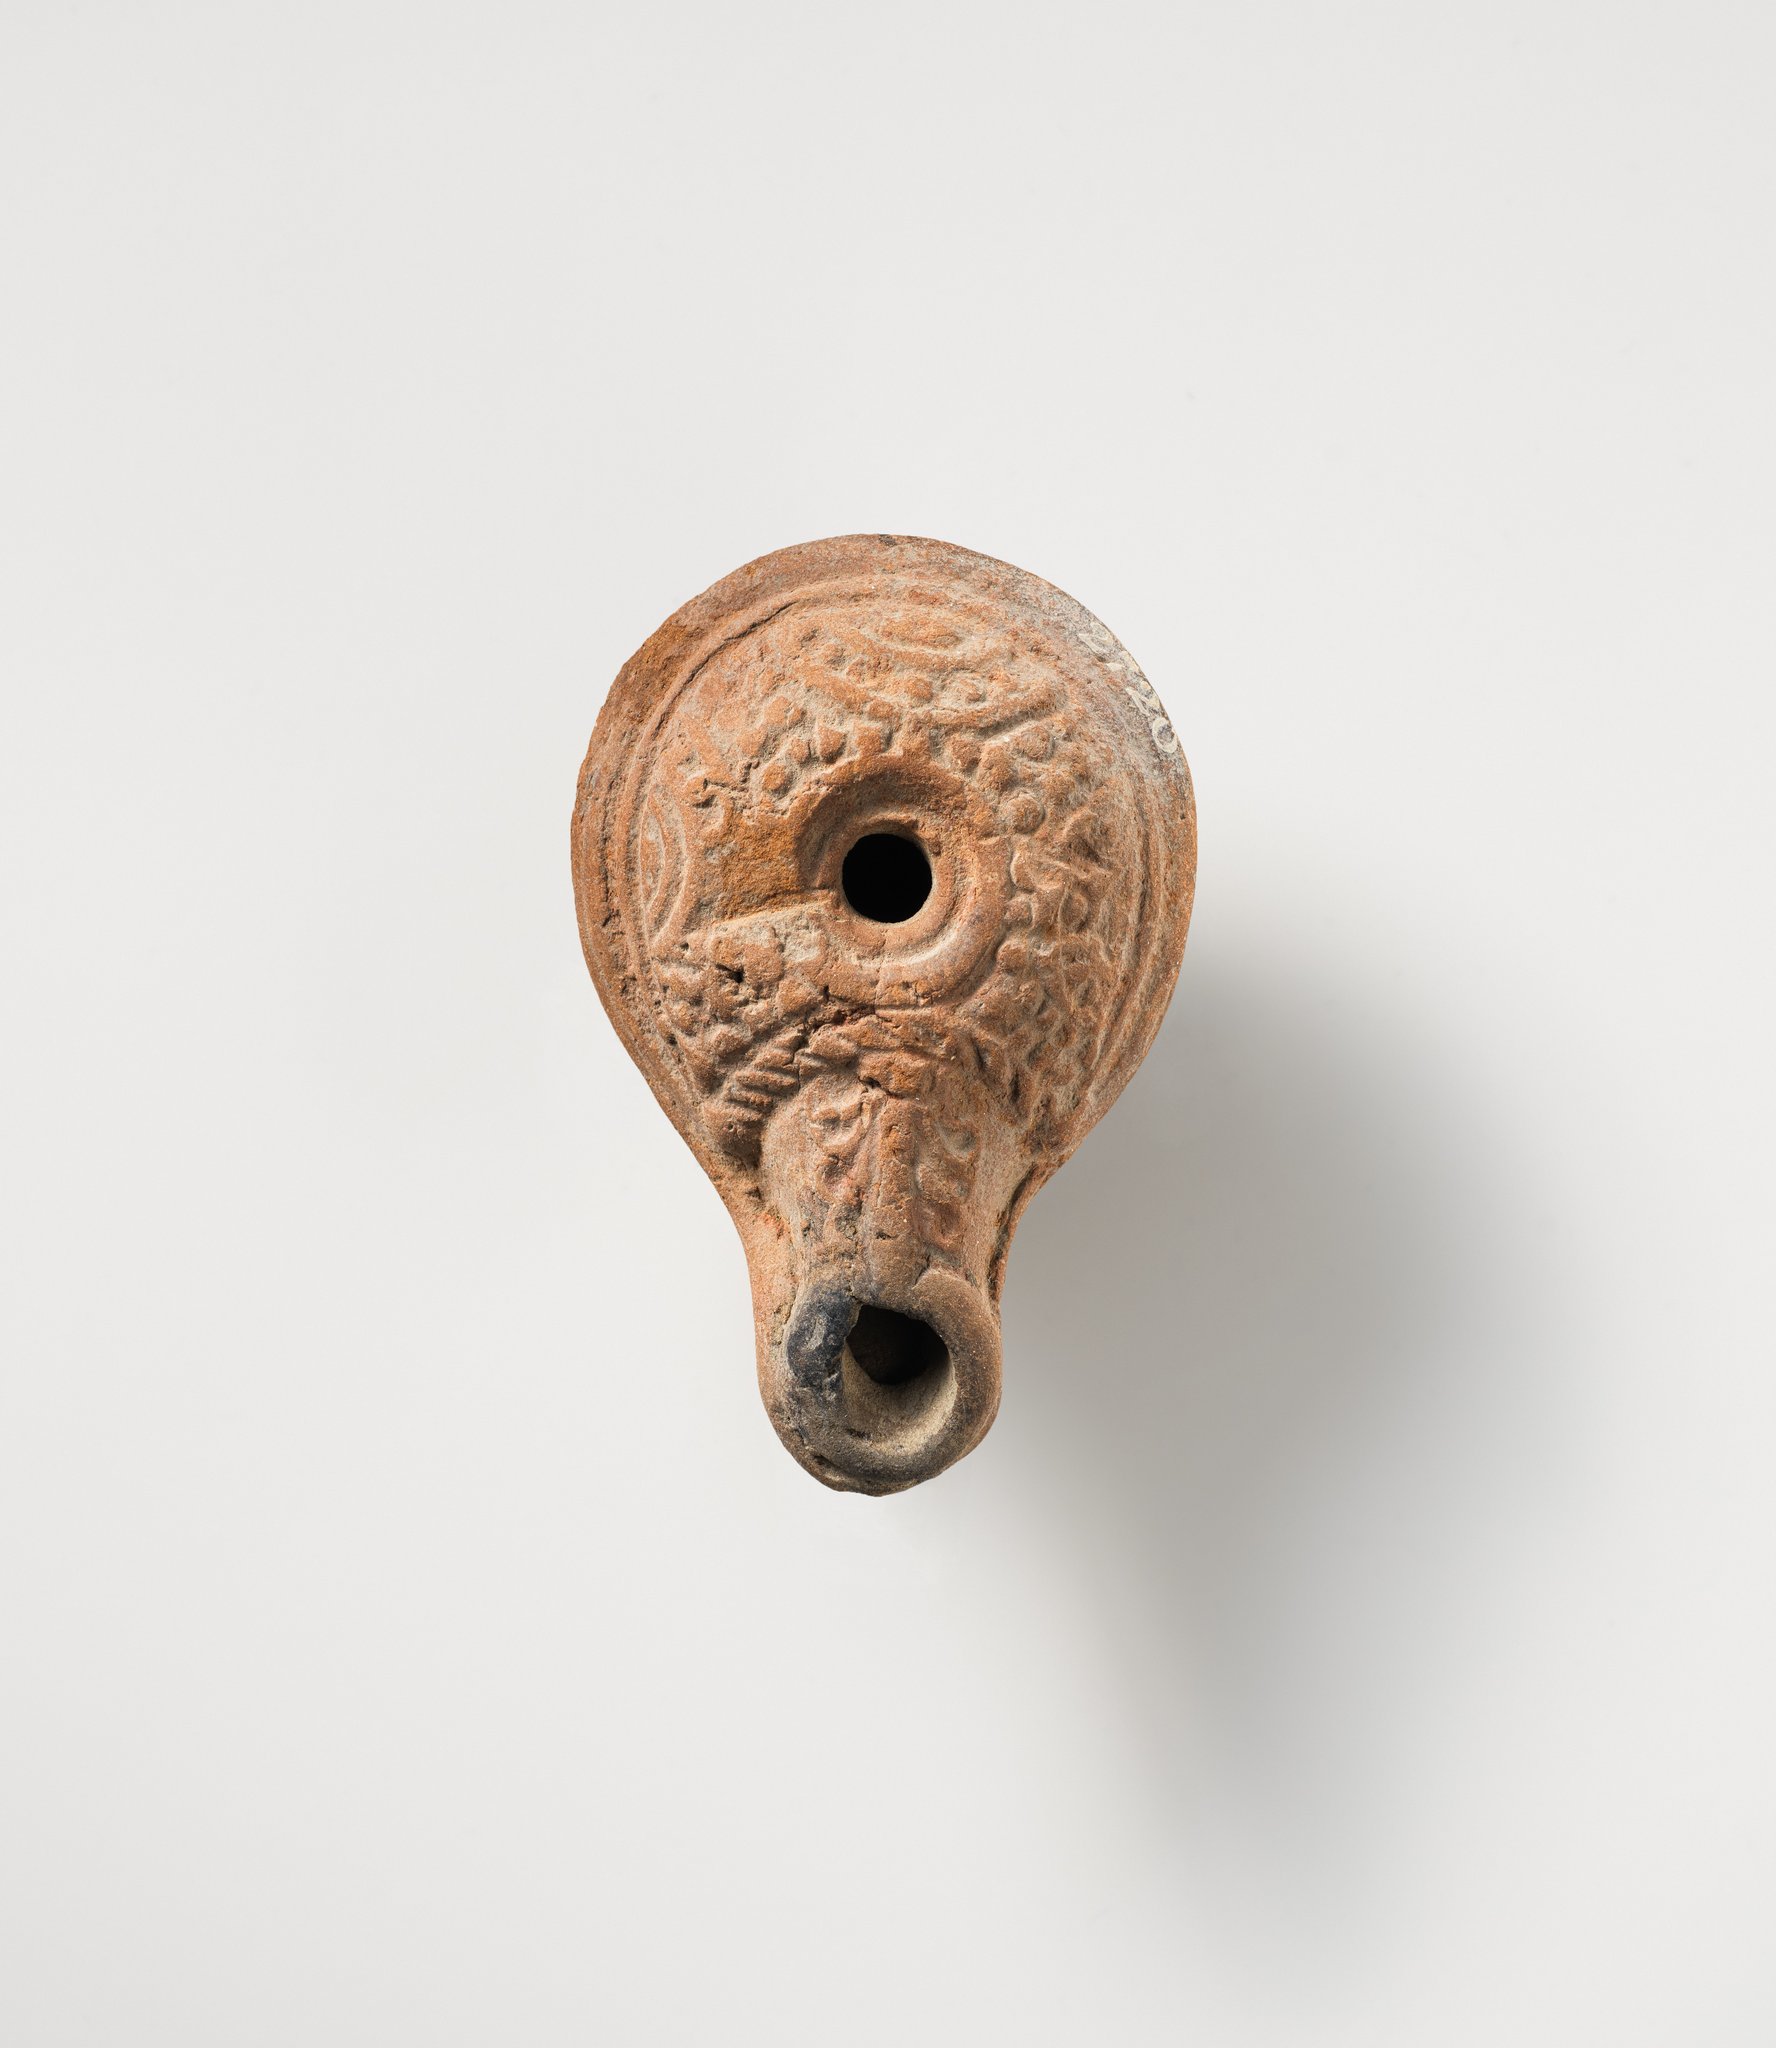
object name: lamp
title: Terracotta oil lamp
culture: greek or roman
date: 100 BCE-100 CE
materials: terracotta